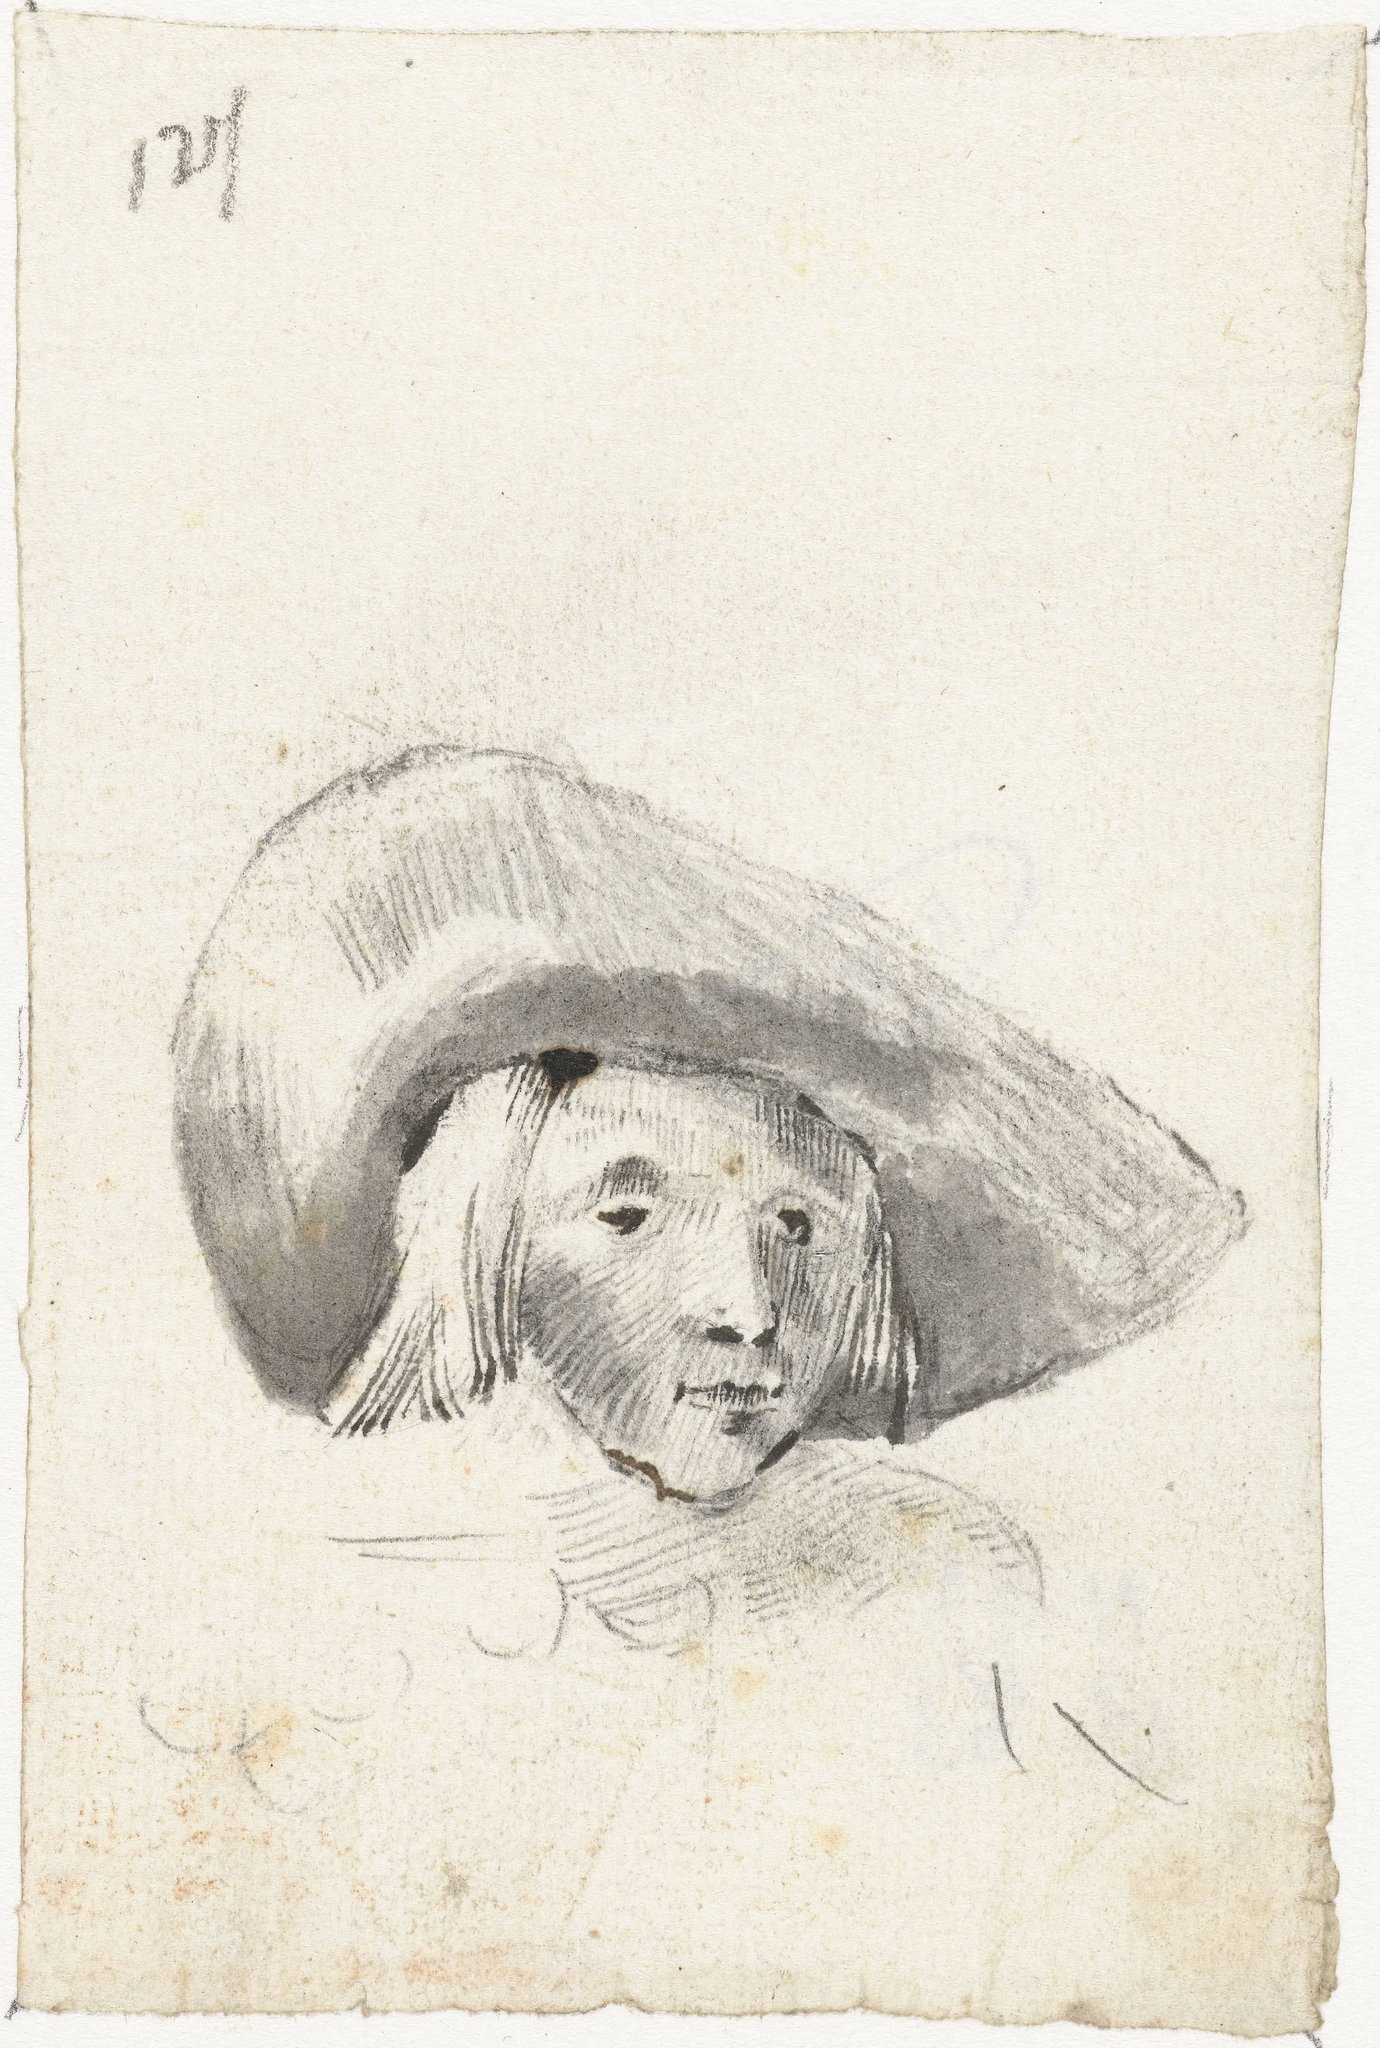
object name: drawing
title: Jongenshoofd met een breedgerande hoed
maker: moses ter borch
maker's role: draughtsman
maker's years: 1645-1667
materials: chalk, ink, paper, pencil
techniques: brush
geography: zwolle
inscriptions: annotation: ‘127’